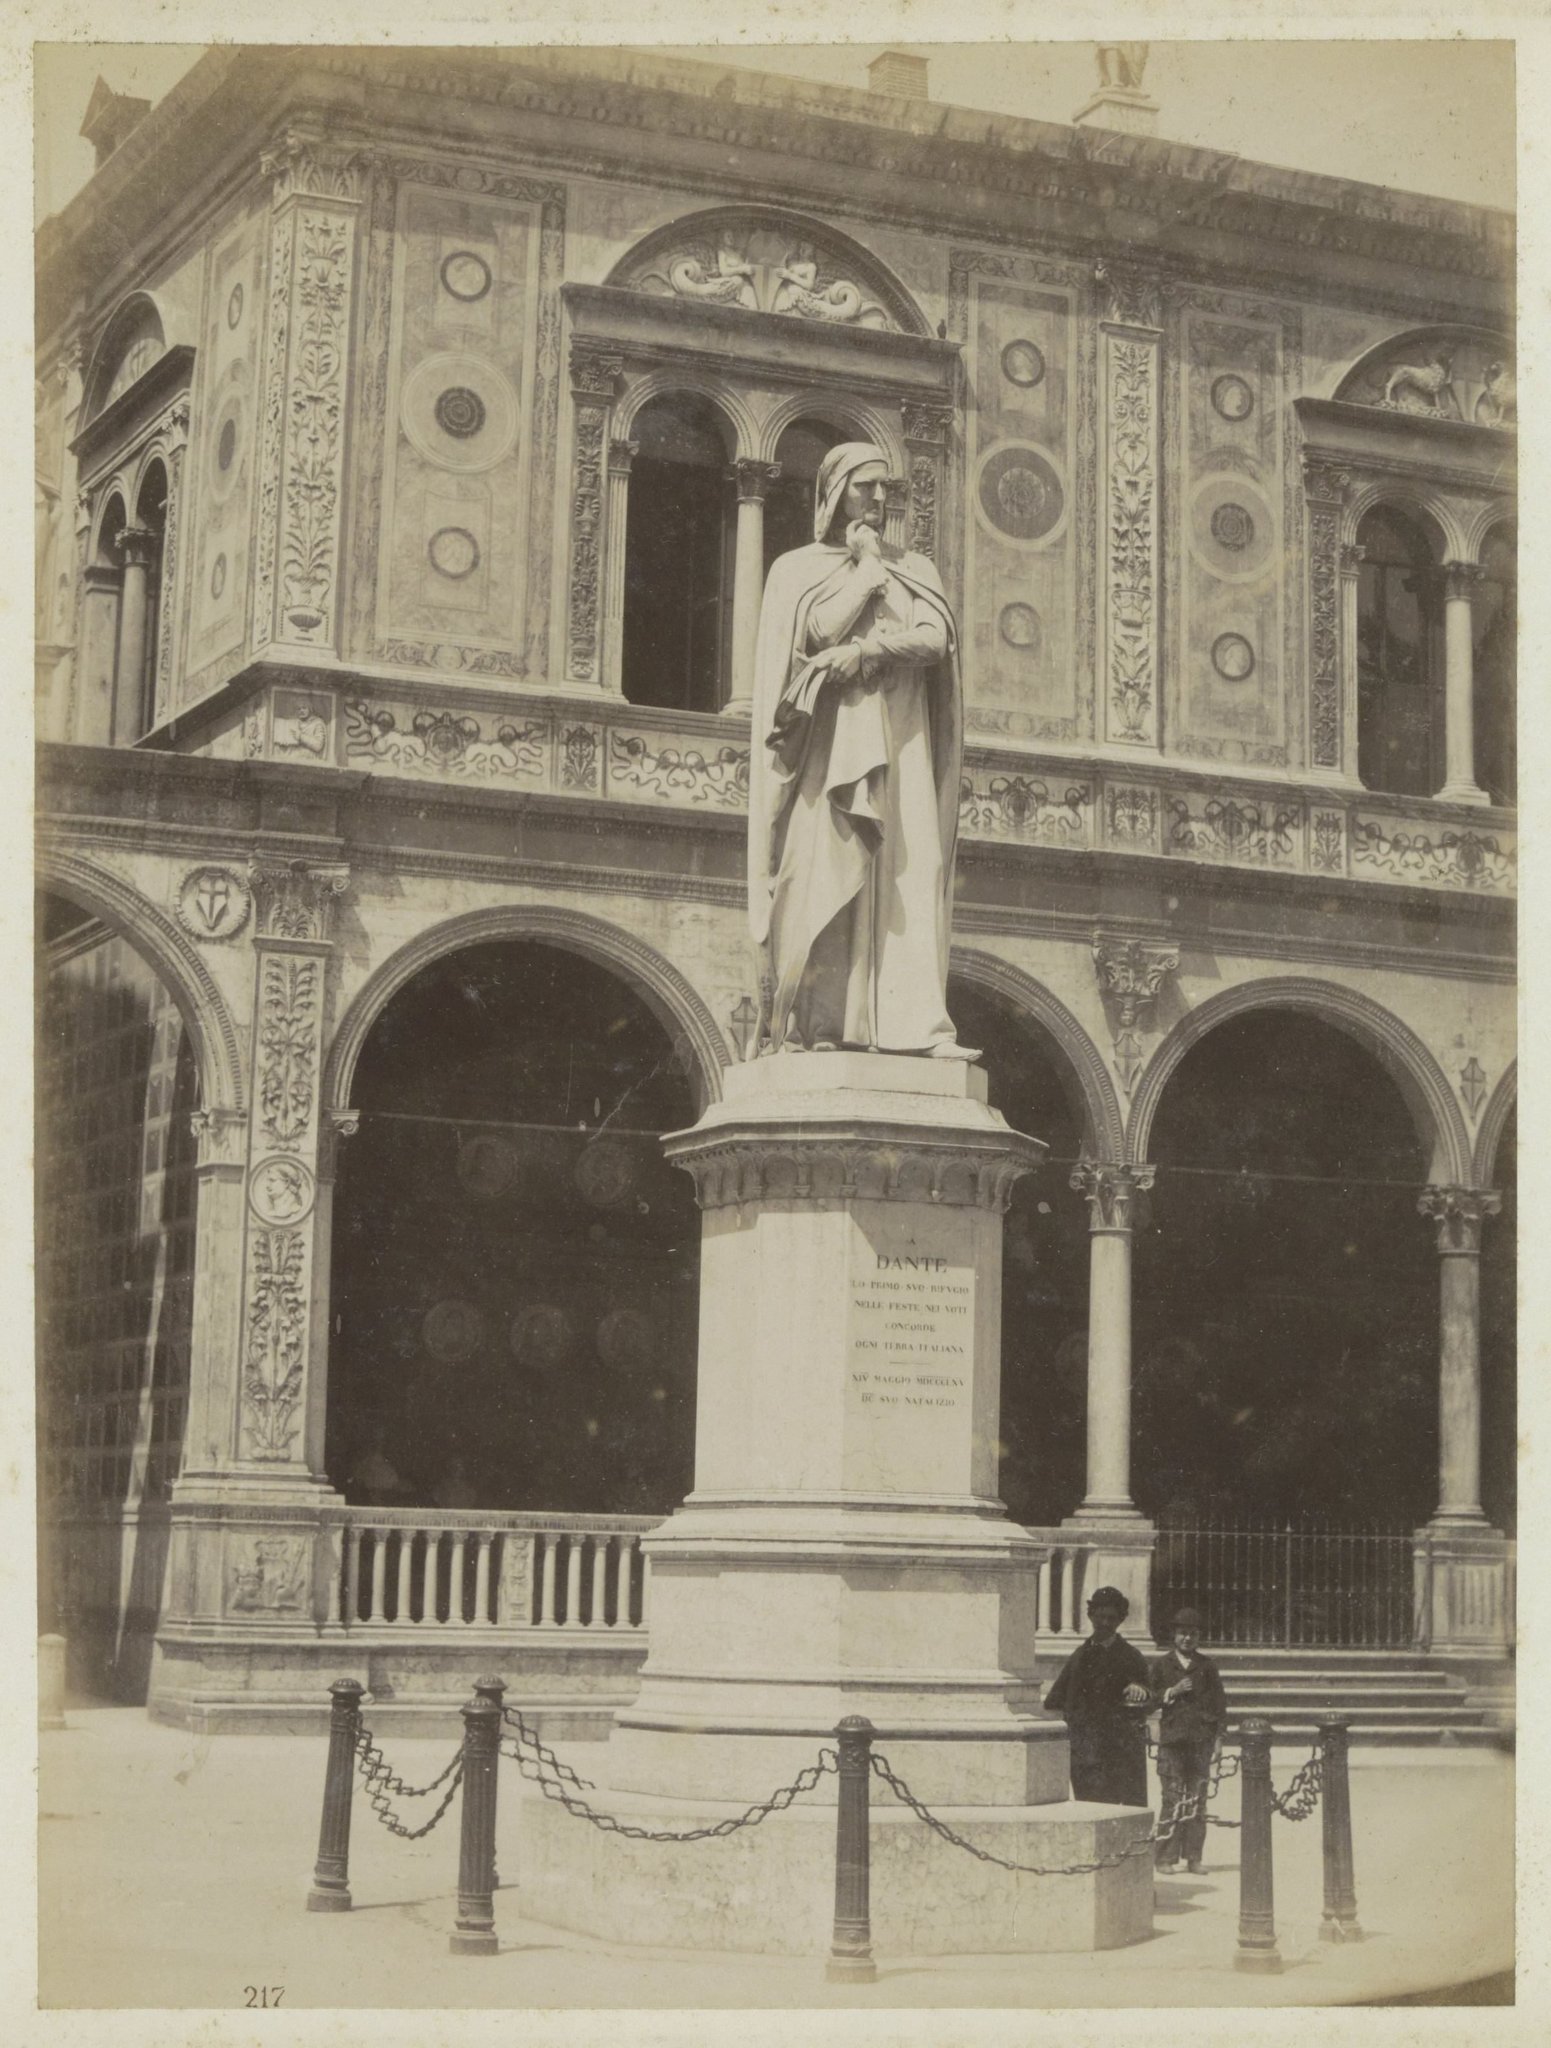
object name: photograph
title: Standbeeld van Dante Alighieri in Verona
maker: Anonymous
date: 1870-1900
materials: paper, photographic support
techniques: albumen print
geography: verona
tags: monument, statue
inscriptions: negative number: ‘217’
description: Onderdeel van Reisalbum met foto's van bezienswaardigheden in Italië en Frankrijk.